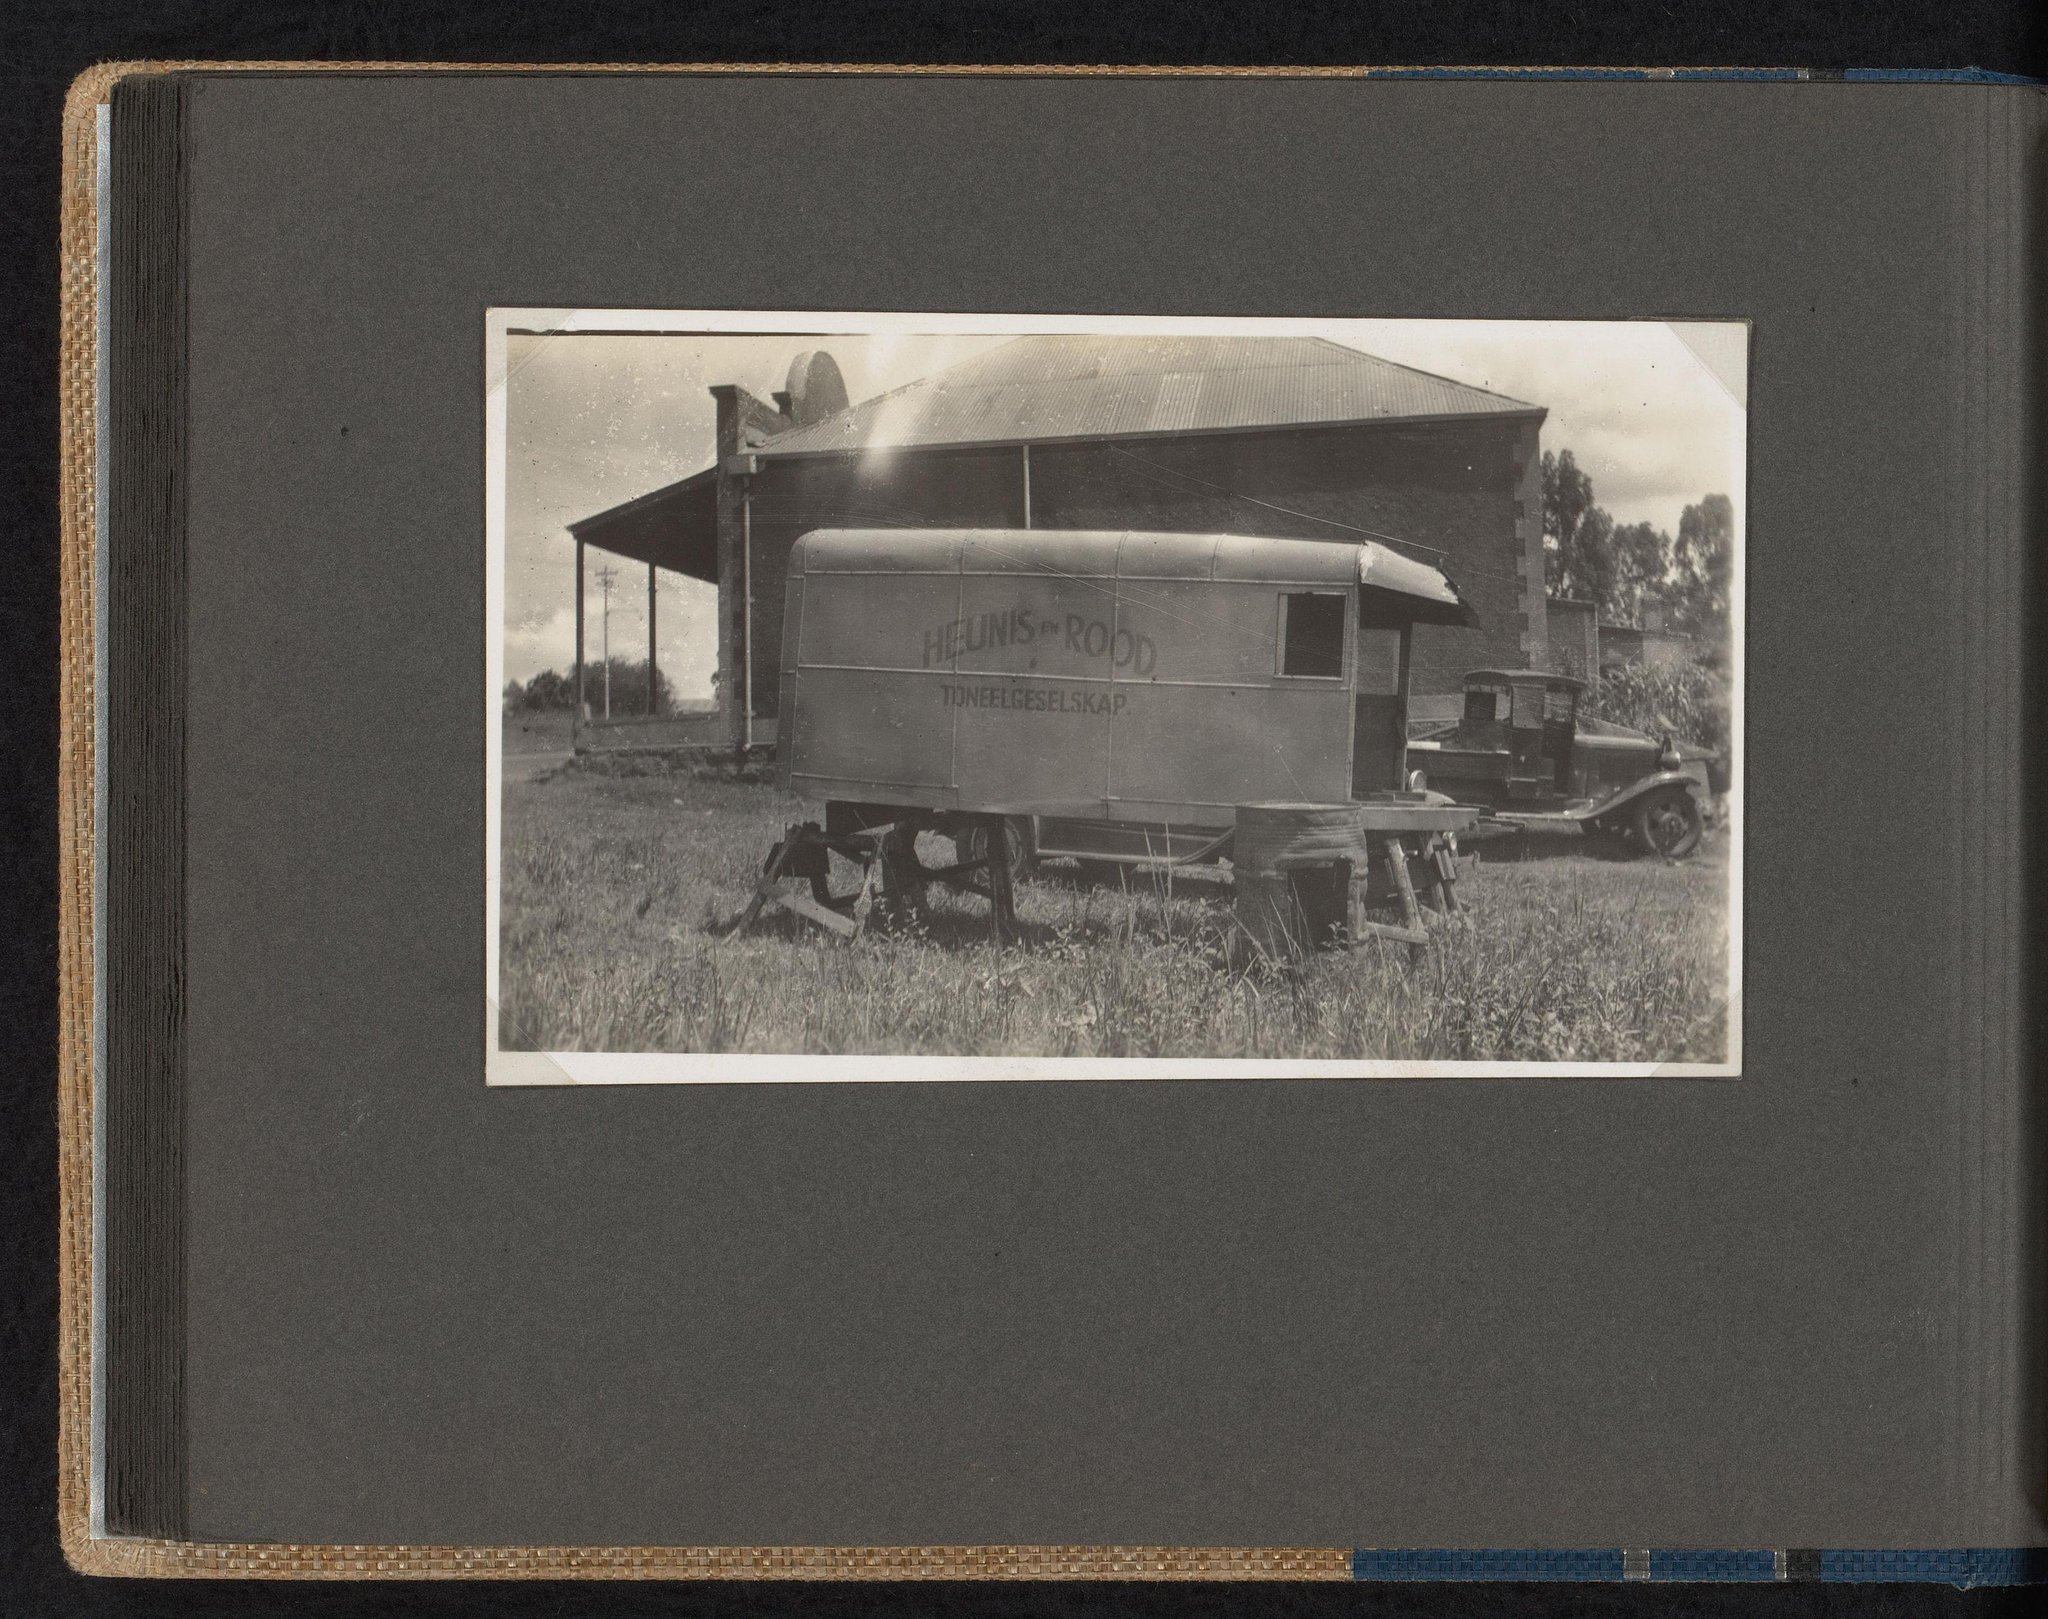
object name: photograph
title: Trailer van Heunis & Rood toneelgeselskap, in Zuid-Afrika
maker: karel frederik van den berg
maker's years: 1873-1948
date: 1920-1930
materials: paper, cardboard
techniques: gelatin silver print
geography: south africa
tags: trailer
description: Deze foto's zijn onderdeel van een album.